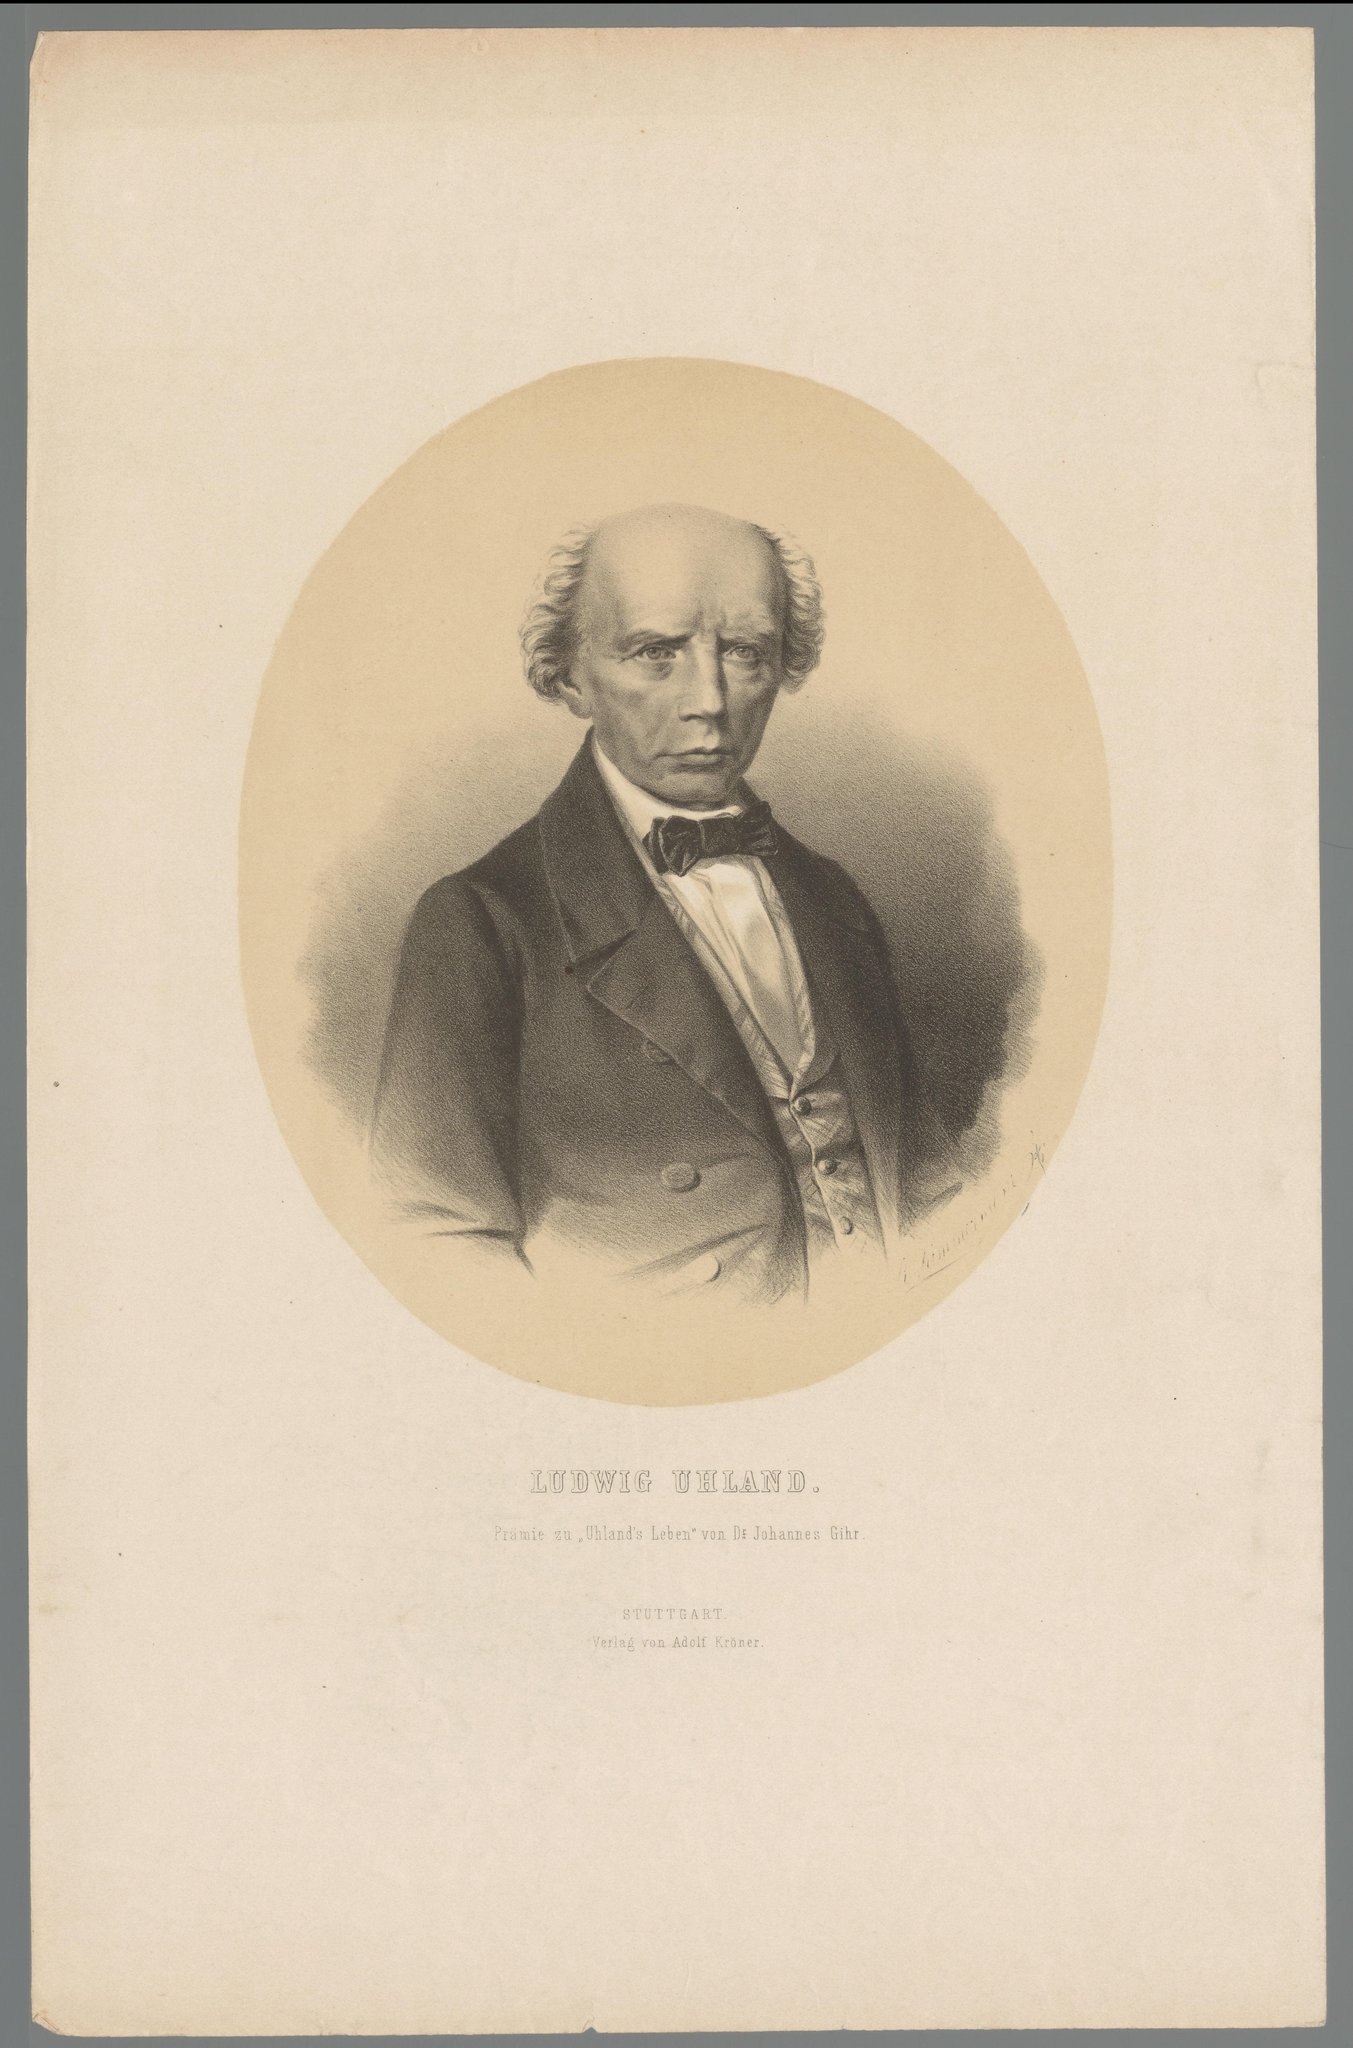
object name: print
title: Ludwig Uhland. Prämie zu "Uhland's Leben" von Dr. Johannes Gihr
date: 1820-1860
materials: paper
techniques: tone lithography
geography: stuttgart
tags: adult man, historical persons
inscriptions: collector's mark: Lugt 2228